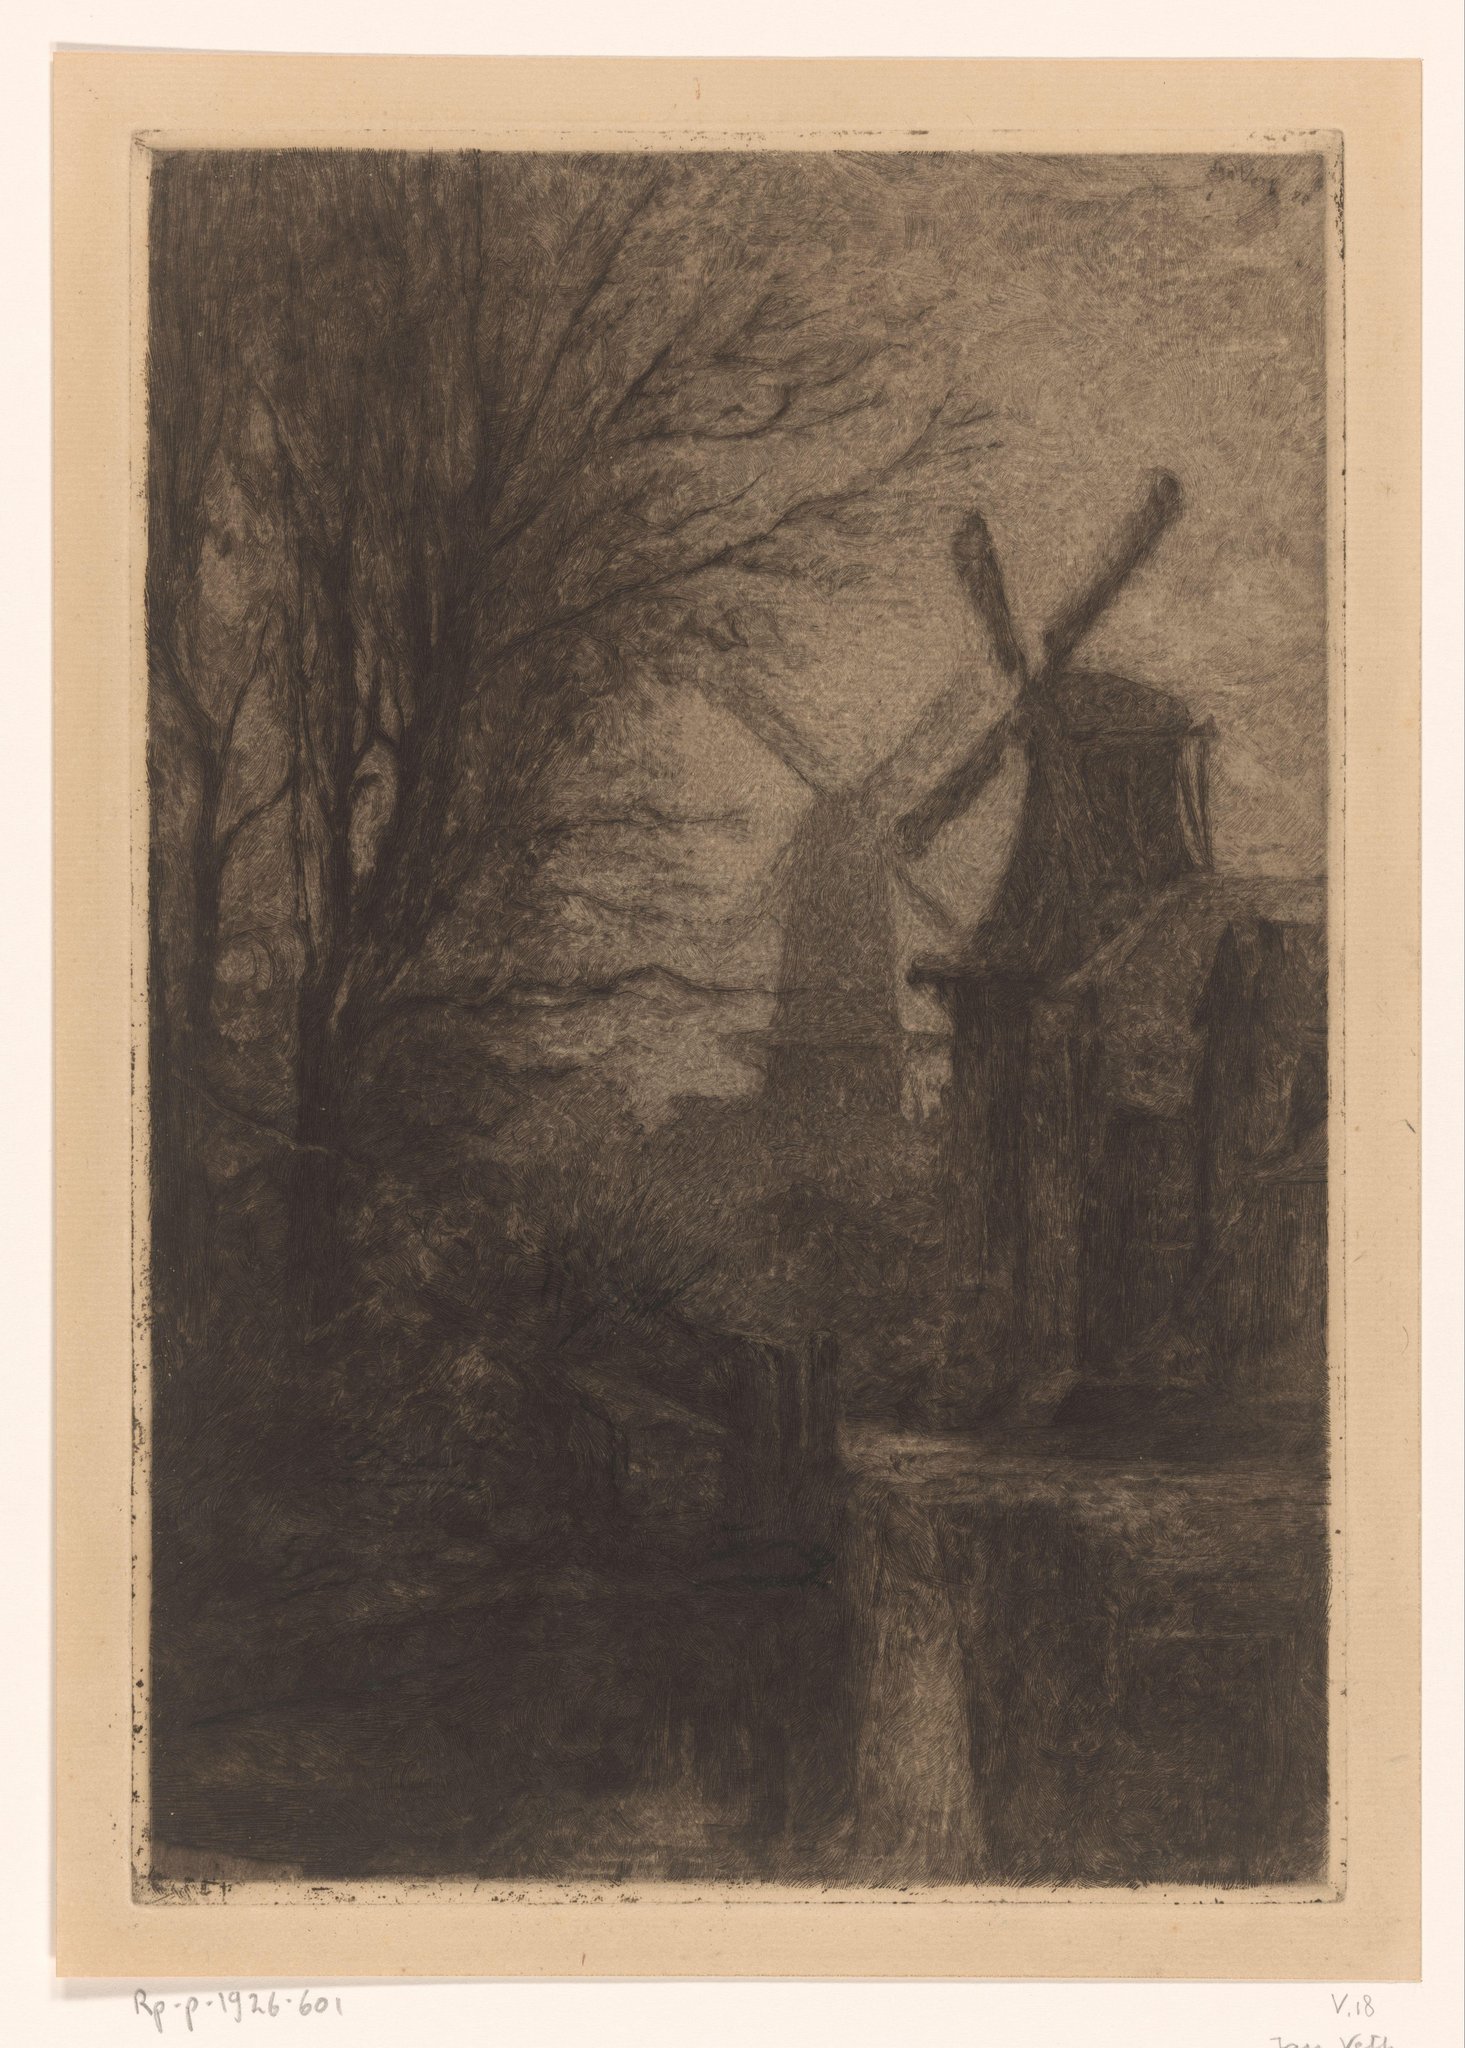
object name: print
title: Molens in avondschemering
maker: jan veth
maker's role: designer, draughtsman, painter, print maker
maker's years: 1864-1925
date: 1886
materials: paper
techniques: etching, intaglio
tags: dusk, evening twilight, windmill in landscape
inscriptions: collector's mark: Lugt 2228